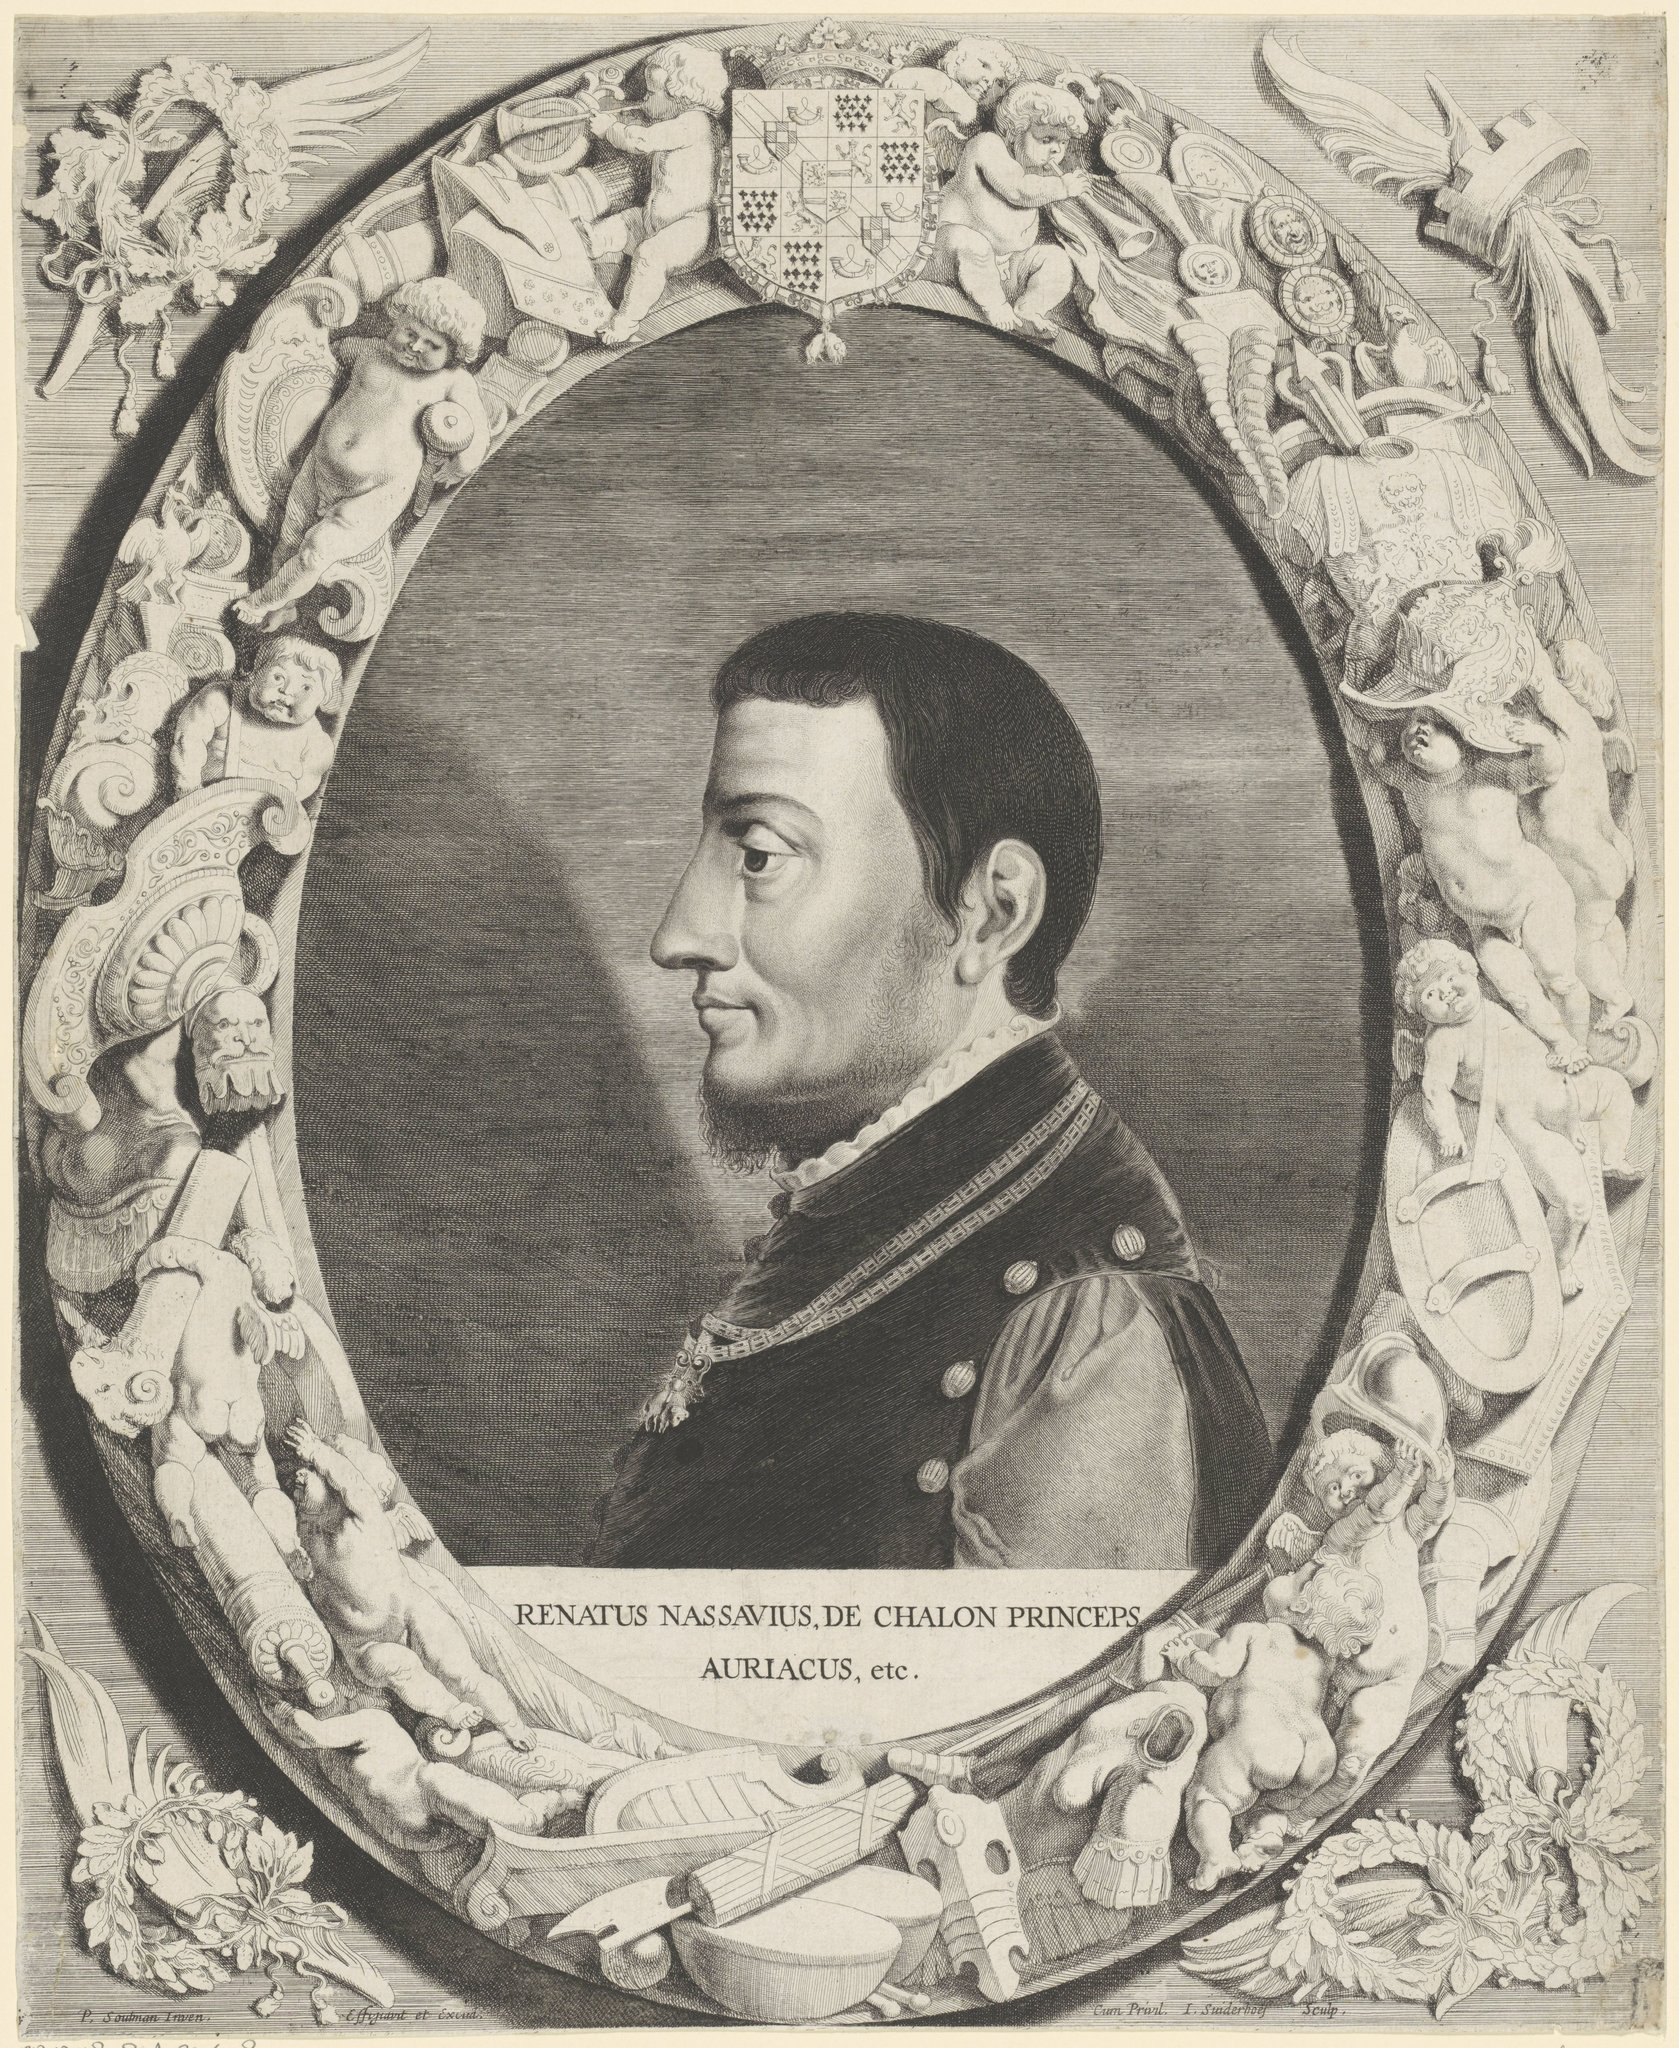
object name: print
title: Comites Nassoviae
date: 1643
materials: paper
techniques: engraving, etching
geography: haarlem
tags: knighthood order of the golden fleece - insignia of a knighthood order, e.g.: badge, chain (with name of order)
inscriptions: collector's mark: Lugt 2228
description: De hier vermelde titel verwijst naar de hoogst verkregen titel van de geportretteerde, niet per se naar de titel die de geportretteerde op deze voorstelling draagt.